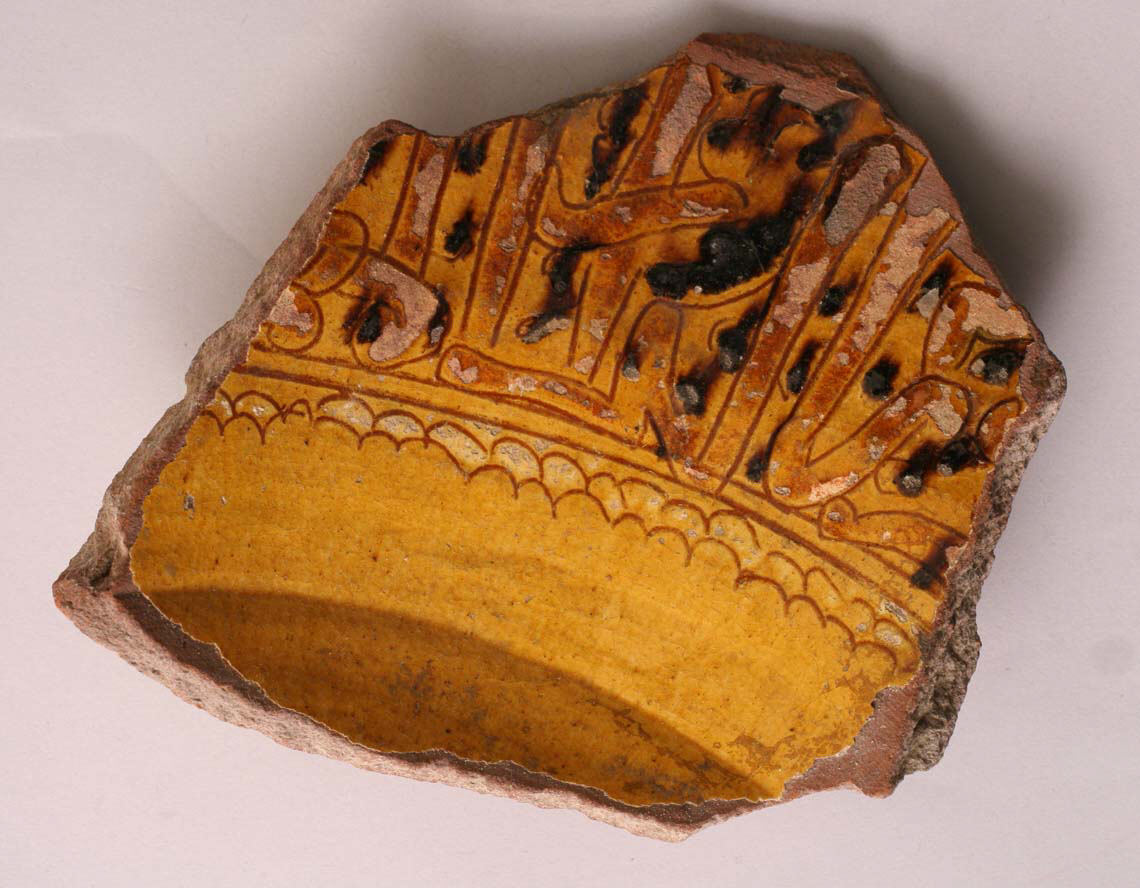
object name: fragment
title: Ceramic Fragment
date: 1301-1500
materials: earthenware, glaze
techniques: coloring, incising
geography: egypt